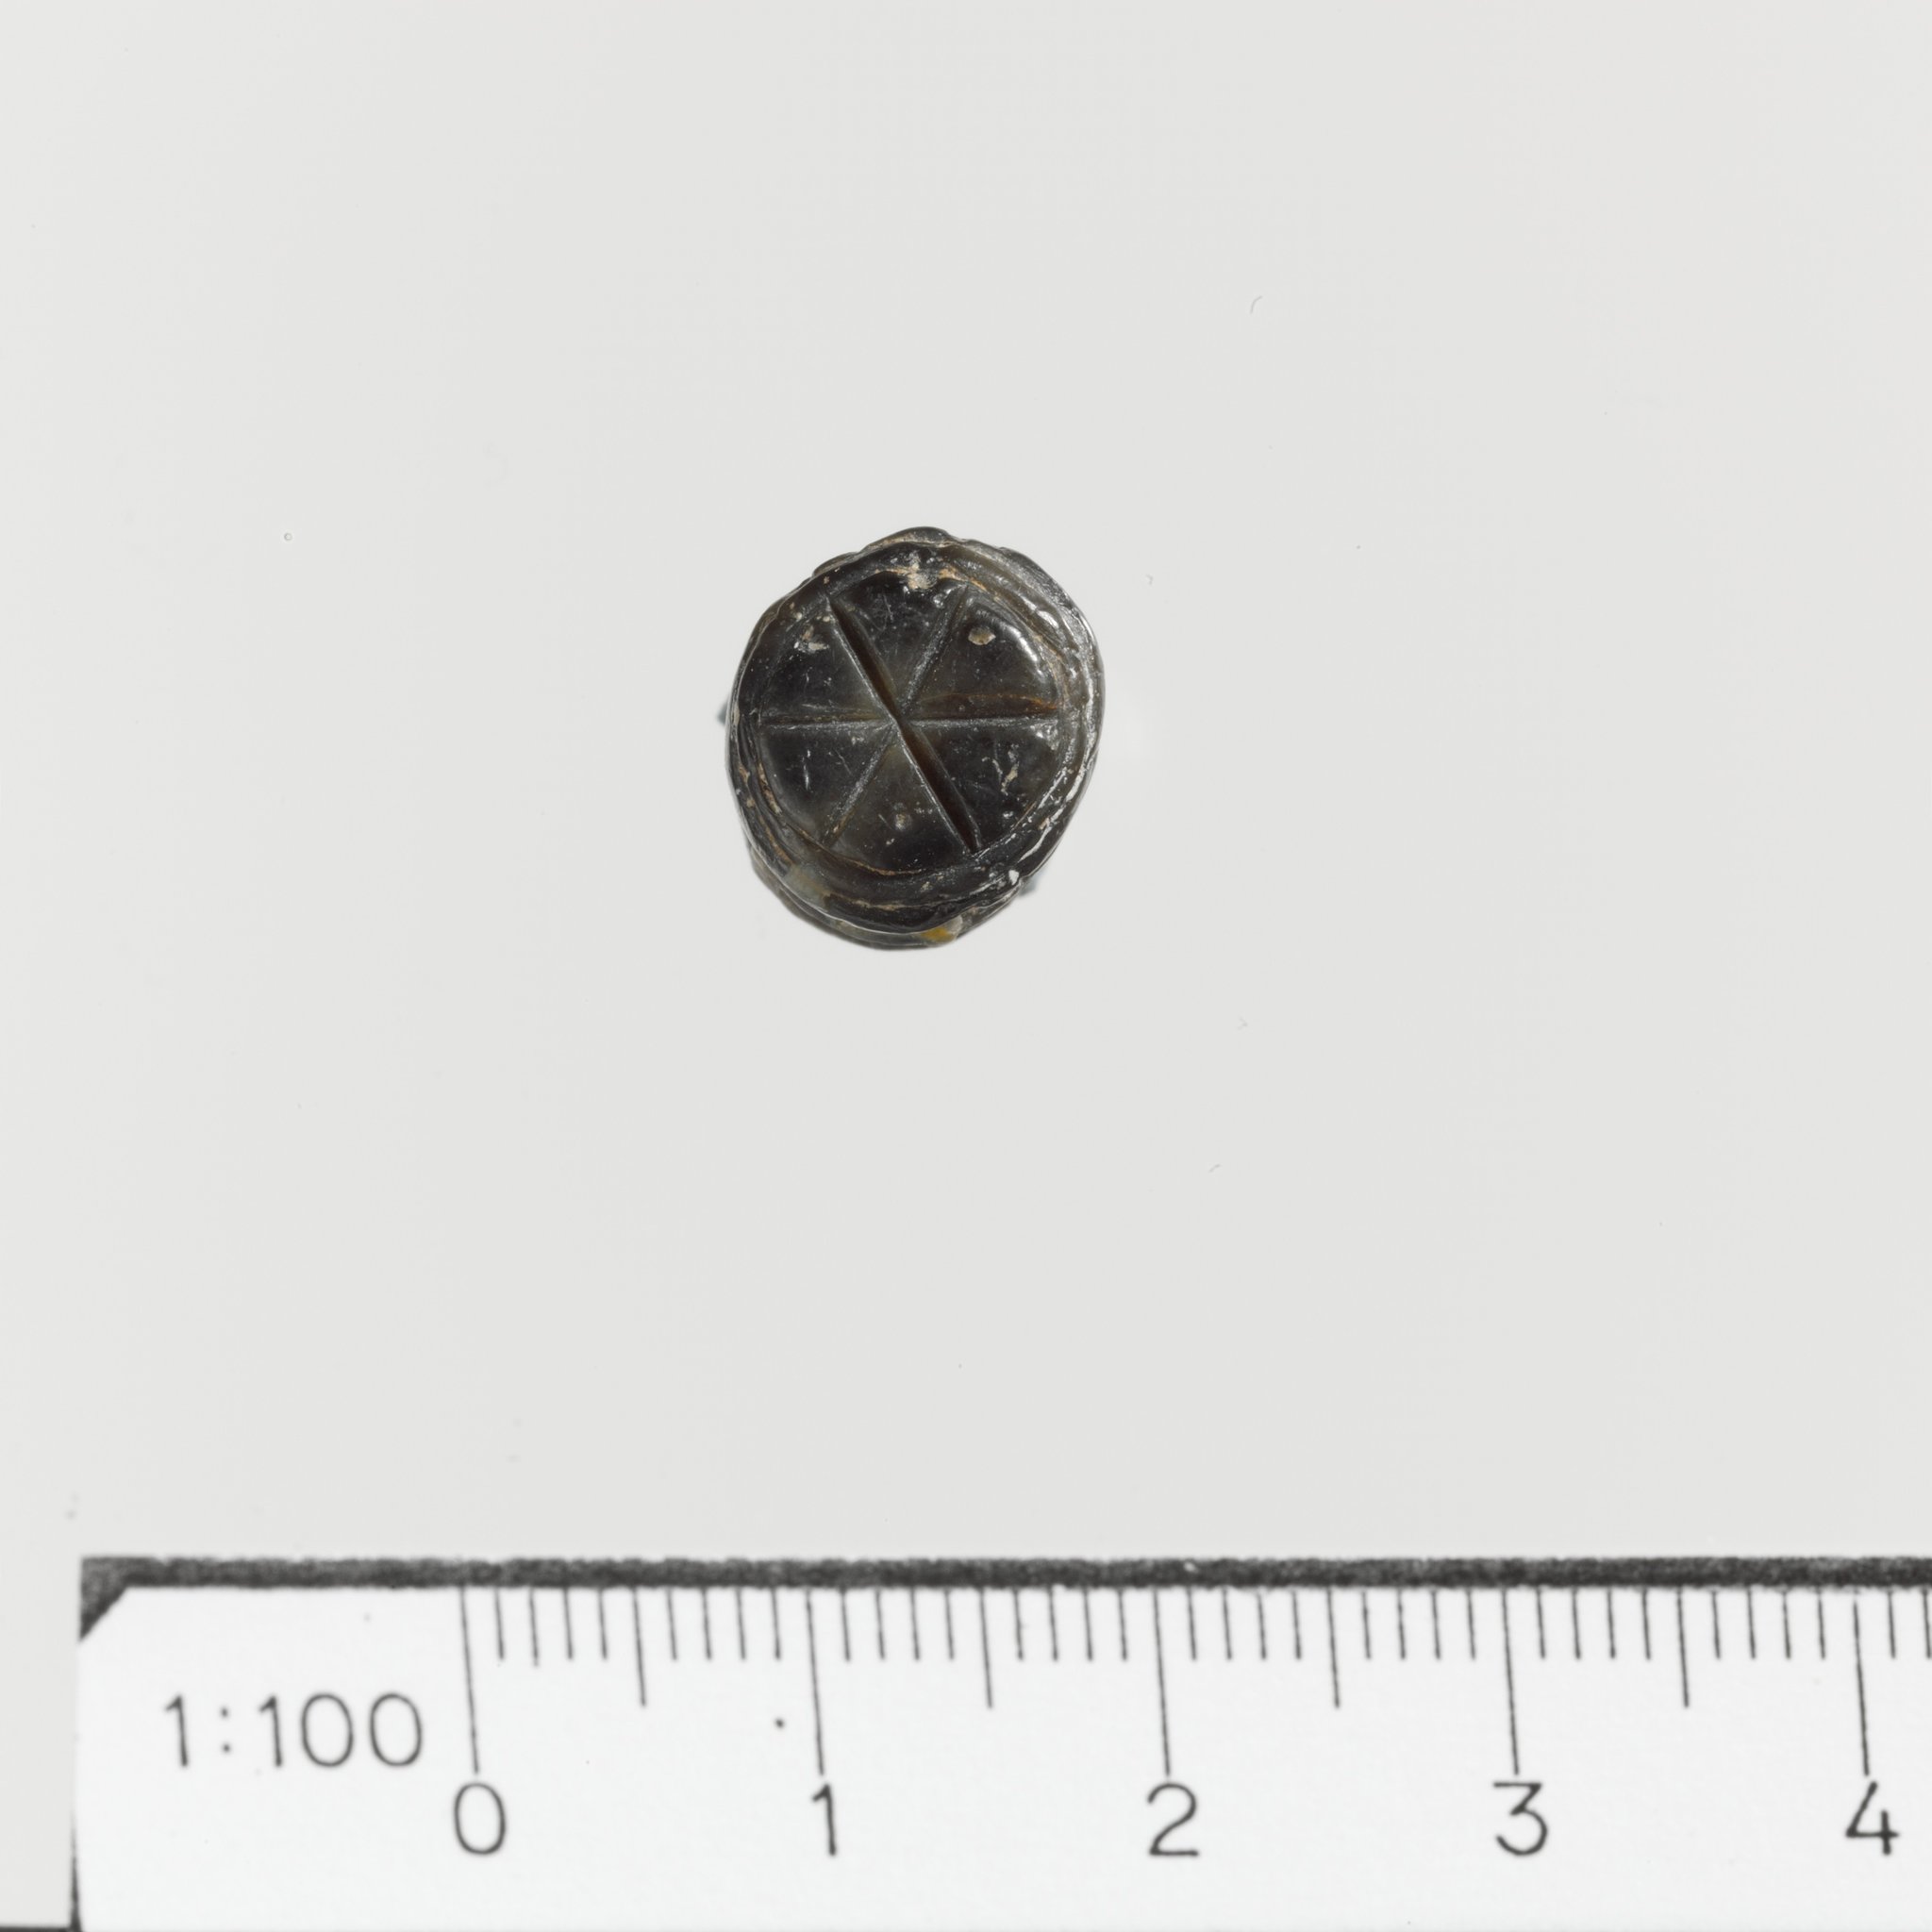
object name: stamp seal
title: Seal stamp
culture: minoan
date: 1800-1700 BCE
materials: stone